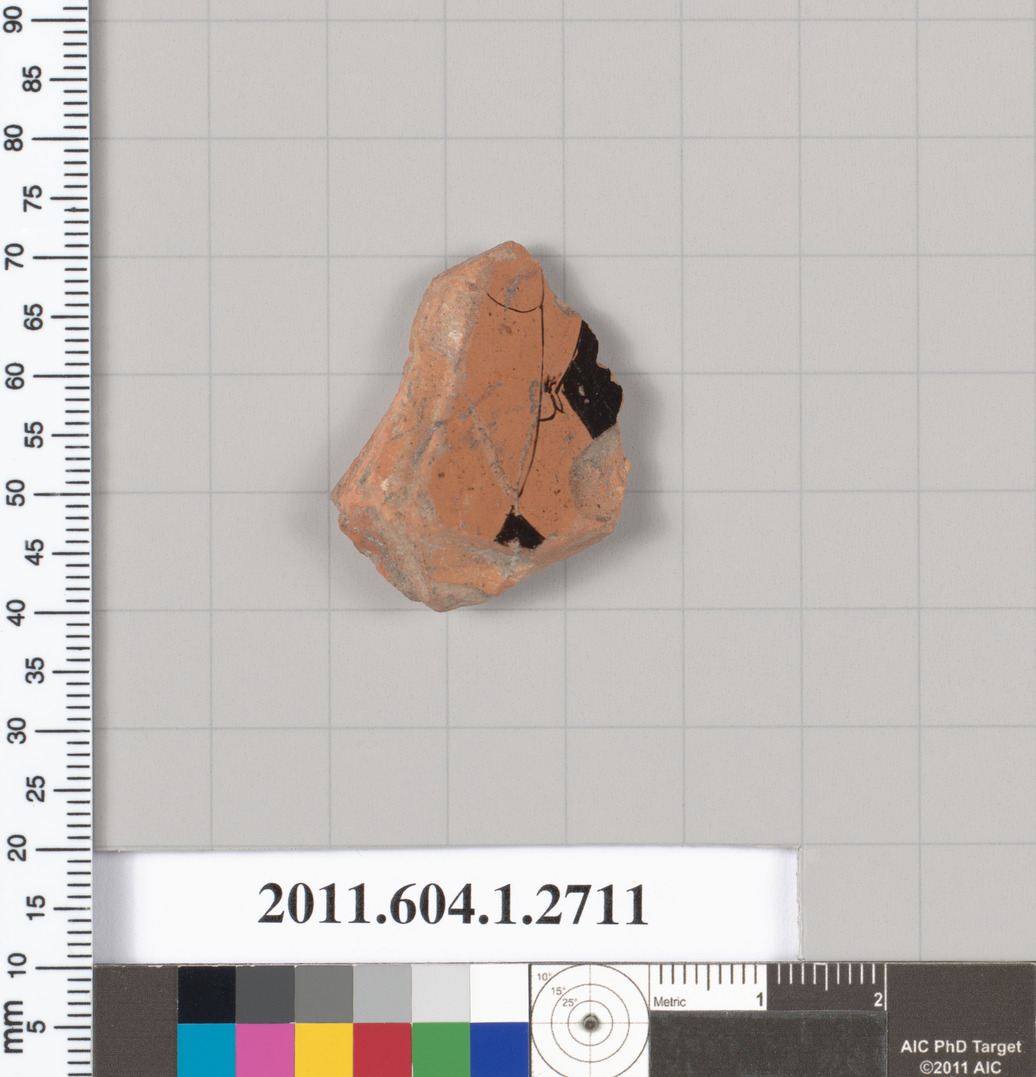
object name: kylix fragment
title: Terracotta fragment of a kylix (drinking cup)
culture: greek, attic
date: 490-470 BCE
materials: terracotta